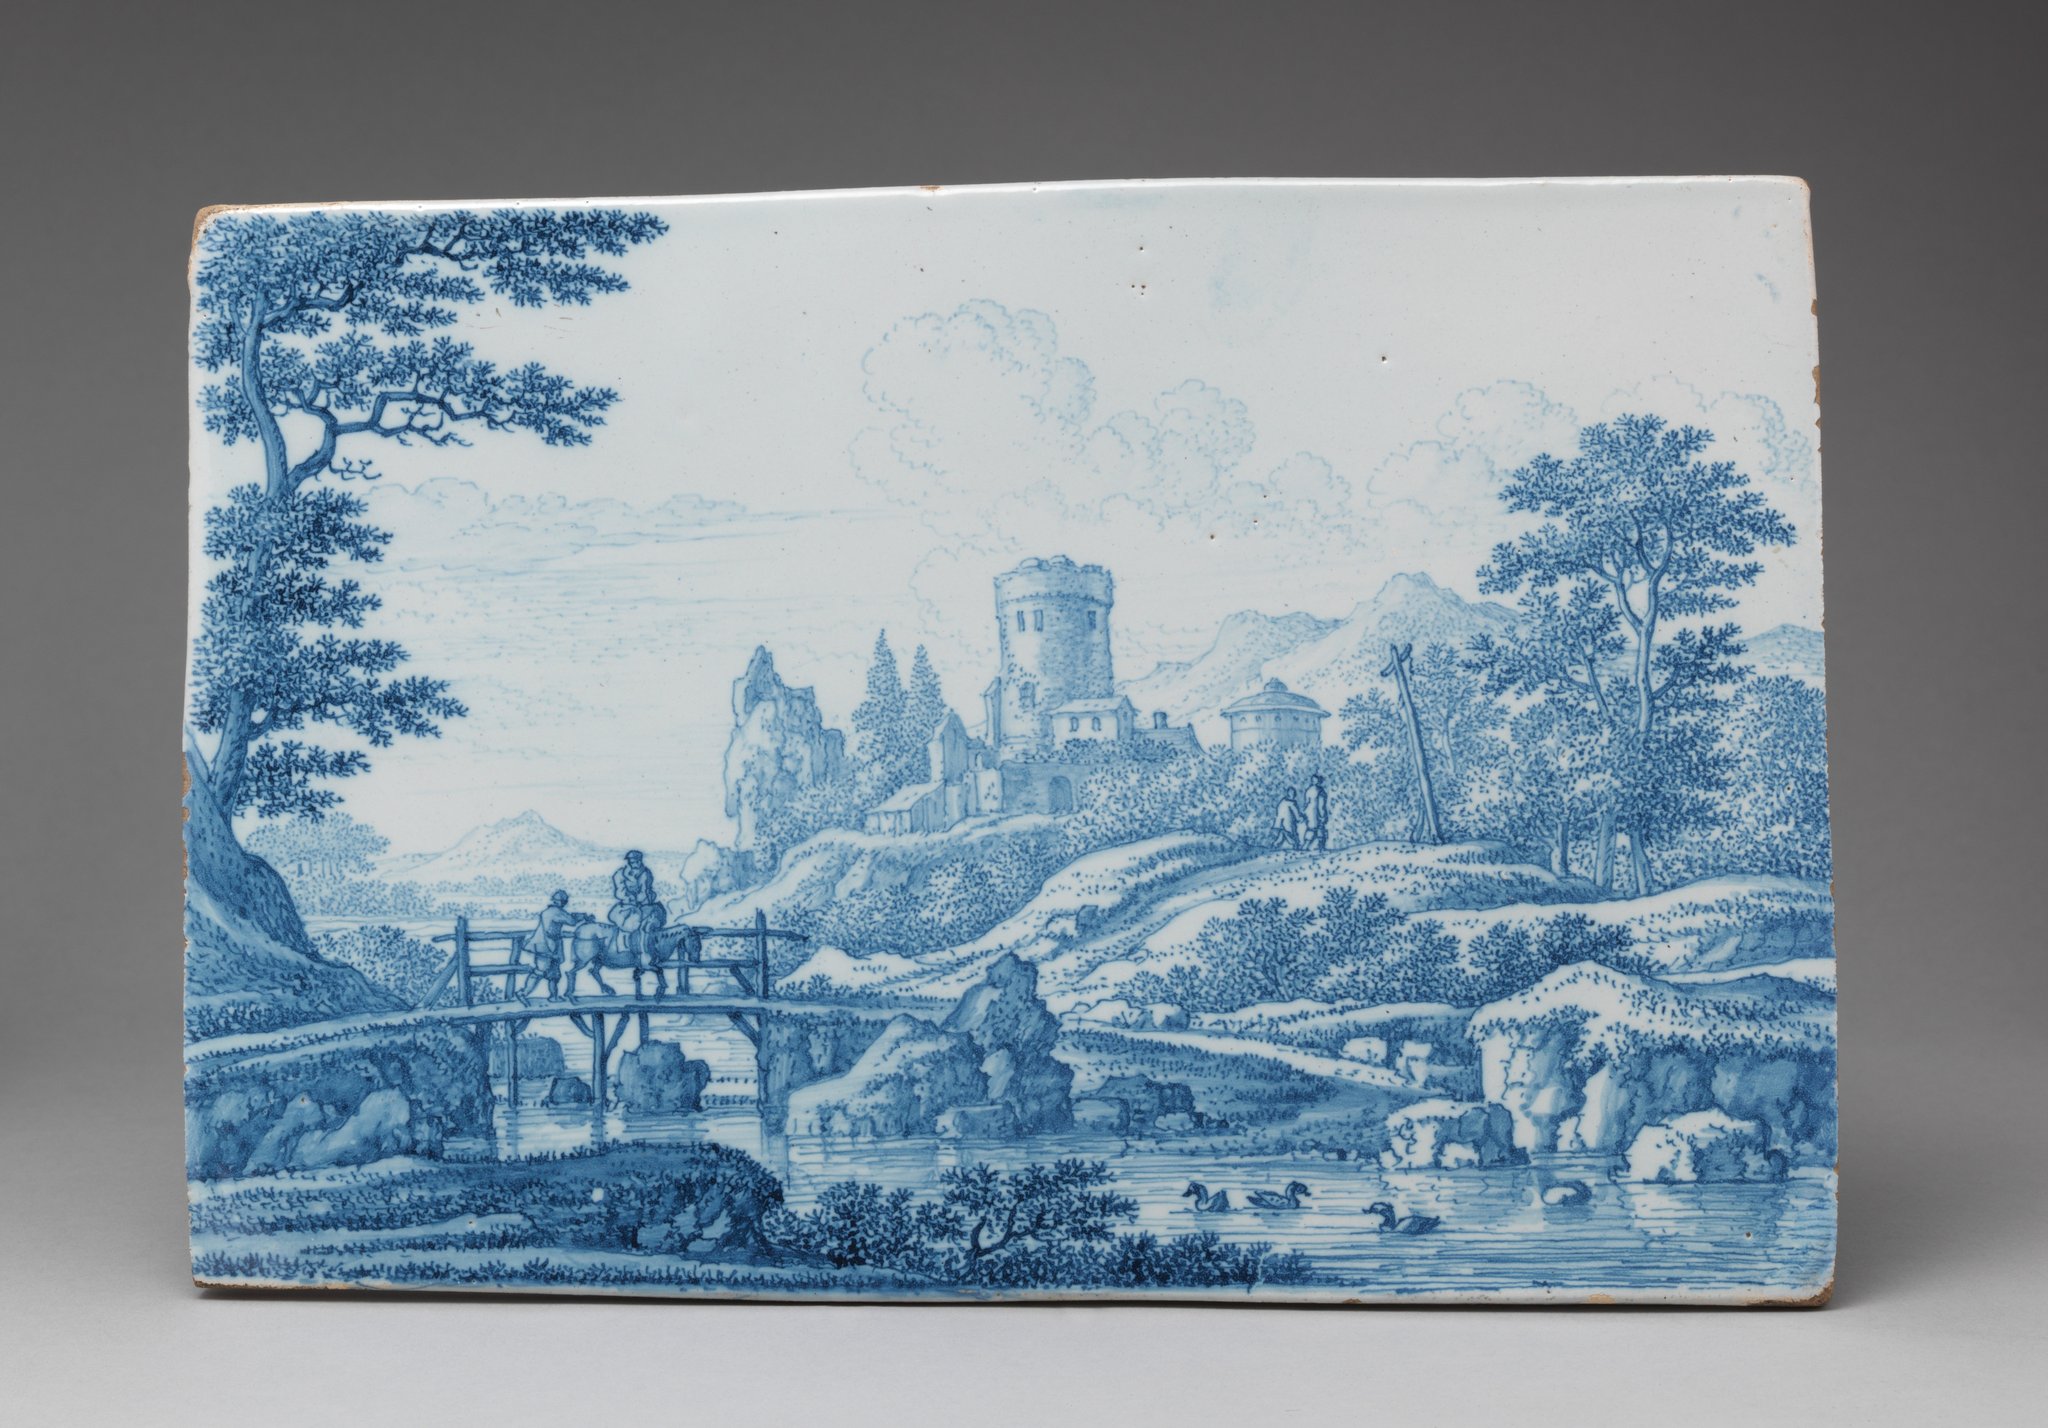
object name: plaque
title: Plaque with an Italinate landscape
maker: frederick van frijtom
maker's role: artist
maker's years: 1632-1702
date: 1660-1692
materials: earthenware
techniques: glazing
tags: castles,bridges,rivers,landscapes